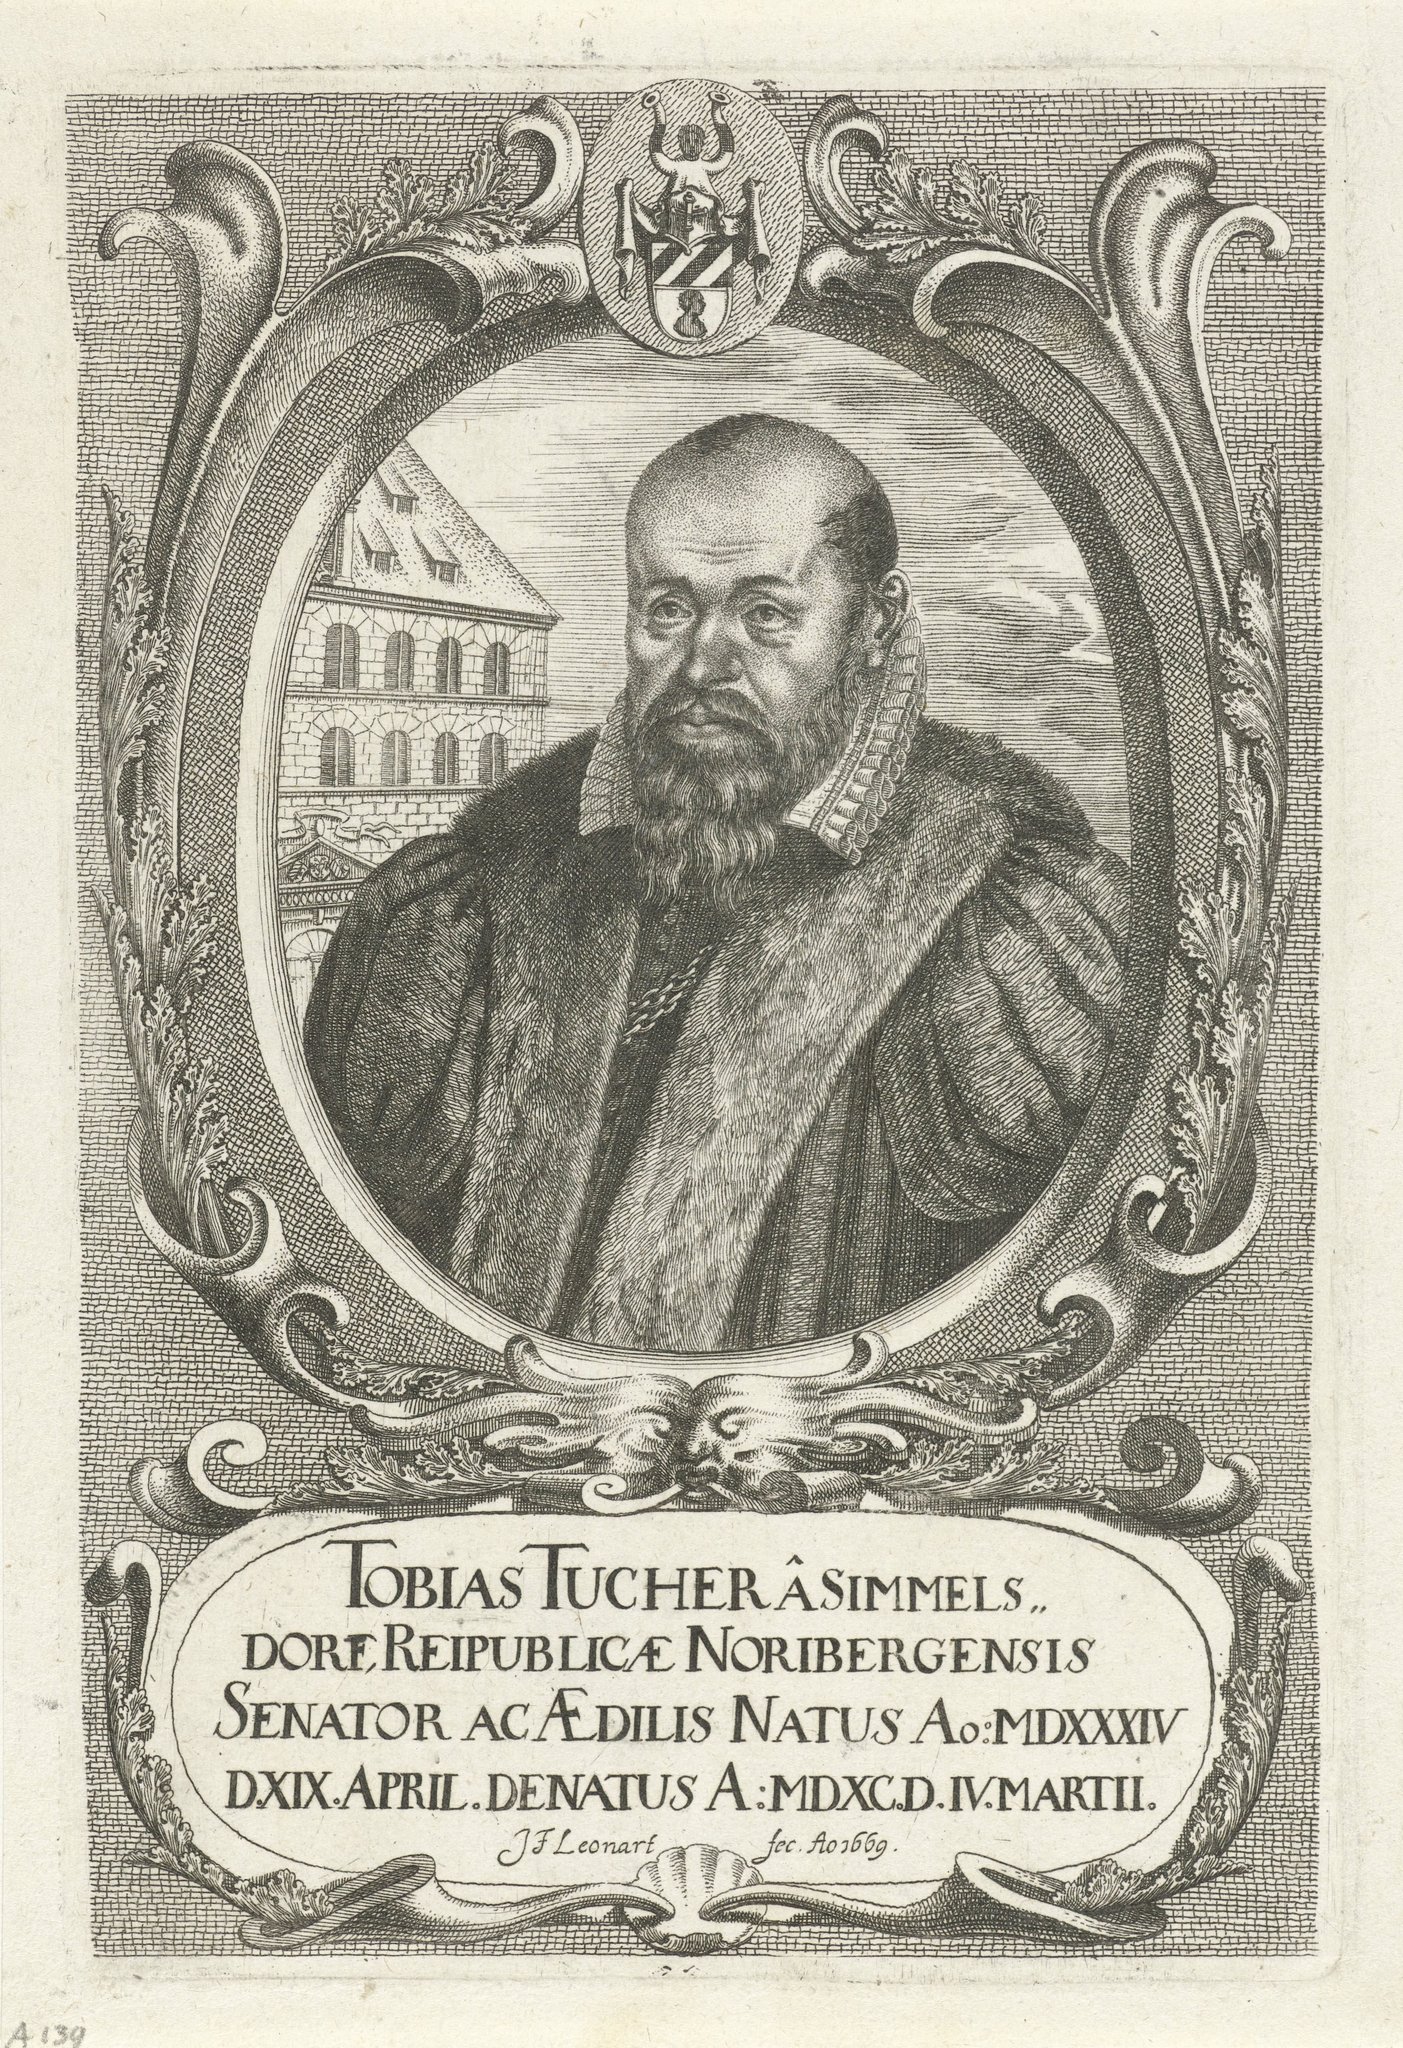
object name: print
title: Portret van Tobias Tucher von Simmelsdorf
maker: johann friedrich leonard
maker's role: print maker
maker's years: 1633-1680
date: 1669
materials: paper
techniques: engraving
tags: neurenberg, raadsheer, senator, tobias tucher von simmelsdorf (i)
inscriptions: collector's mark: Lugt 2228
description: Portret van Tobias Tucher von Simmelsdorf, senator te Neurenberg, met wapenschild.